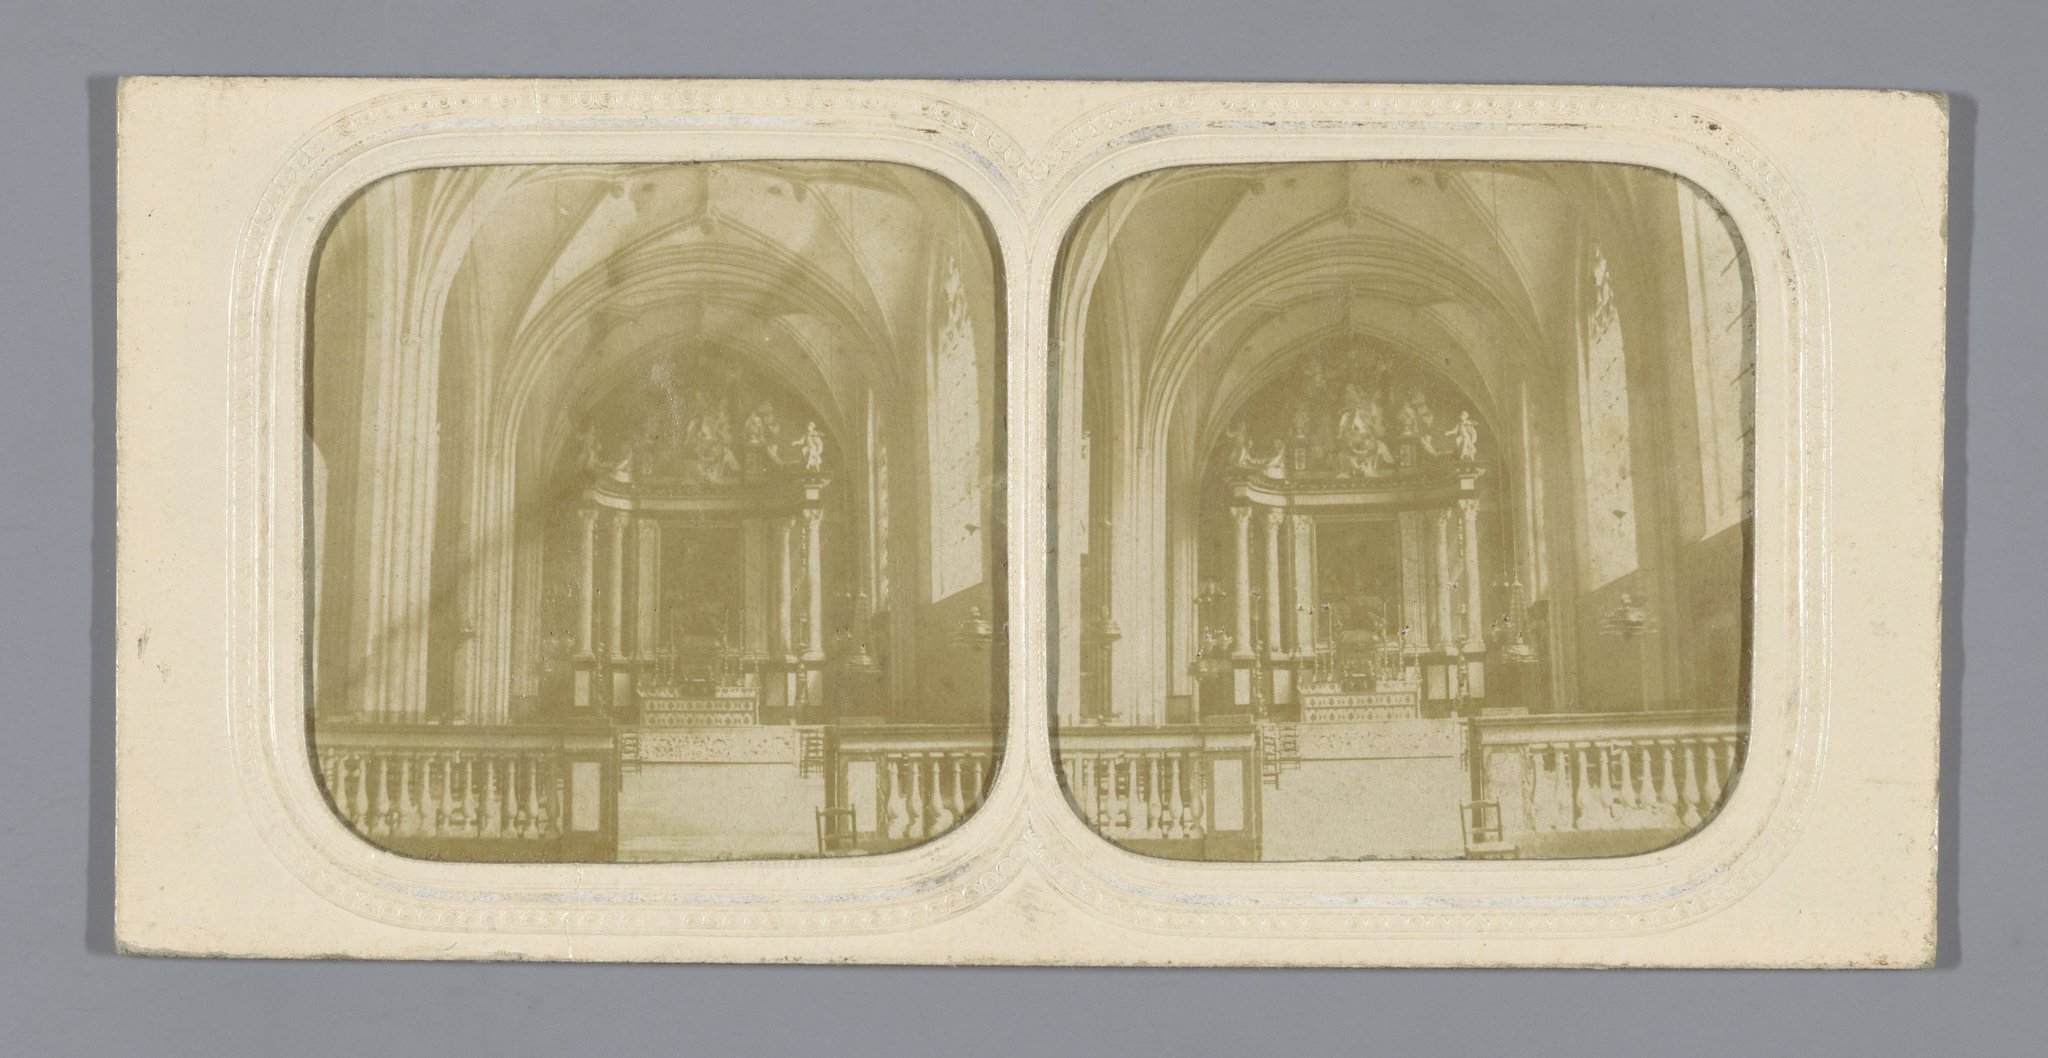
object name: tissue stereograph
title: Interieur van de Onze-Lieve-Vrouwekathedraal in Antwerpen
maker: Anonymous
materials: cardboard, paper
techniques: albumen print, hand coloring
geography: antwerp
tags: parts of church interior: choir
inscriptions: inscription: ‘zelf gekocht in Brussel/ 14 October 1859’, inscription: ‘onze frif v kerk’